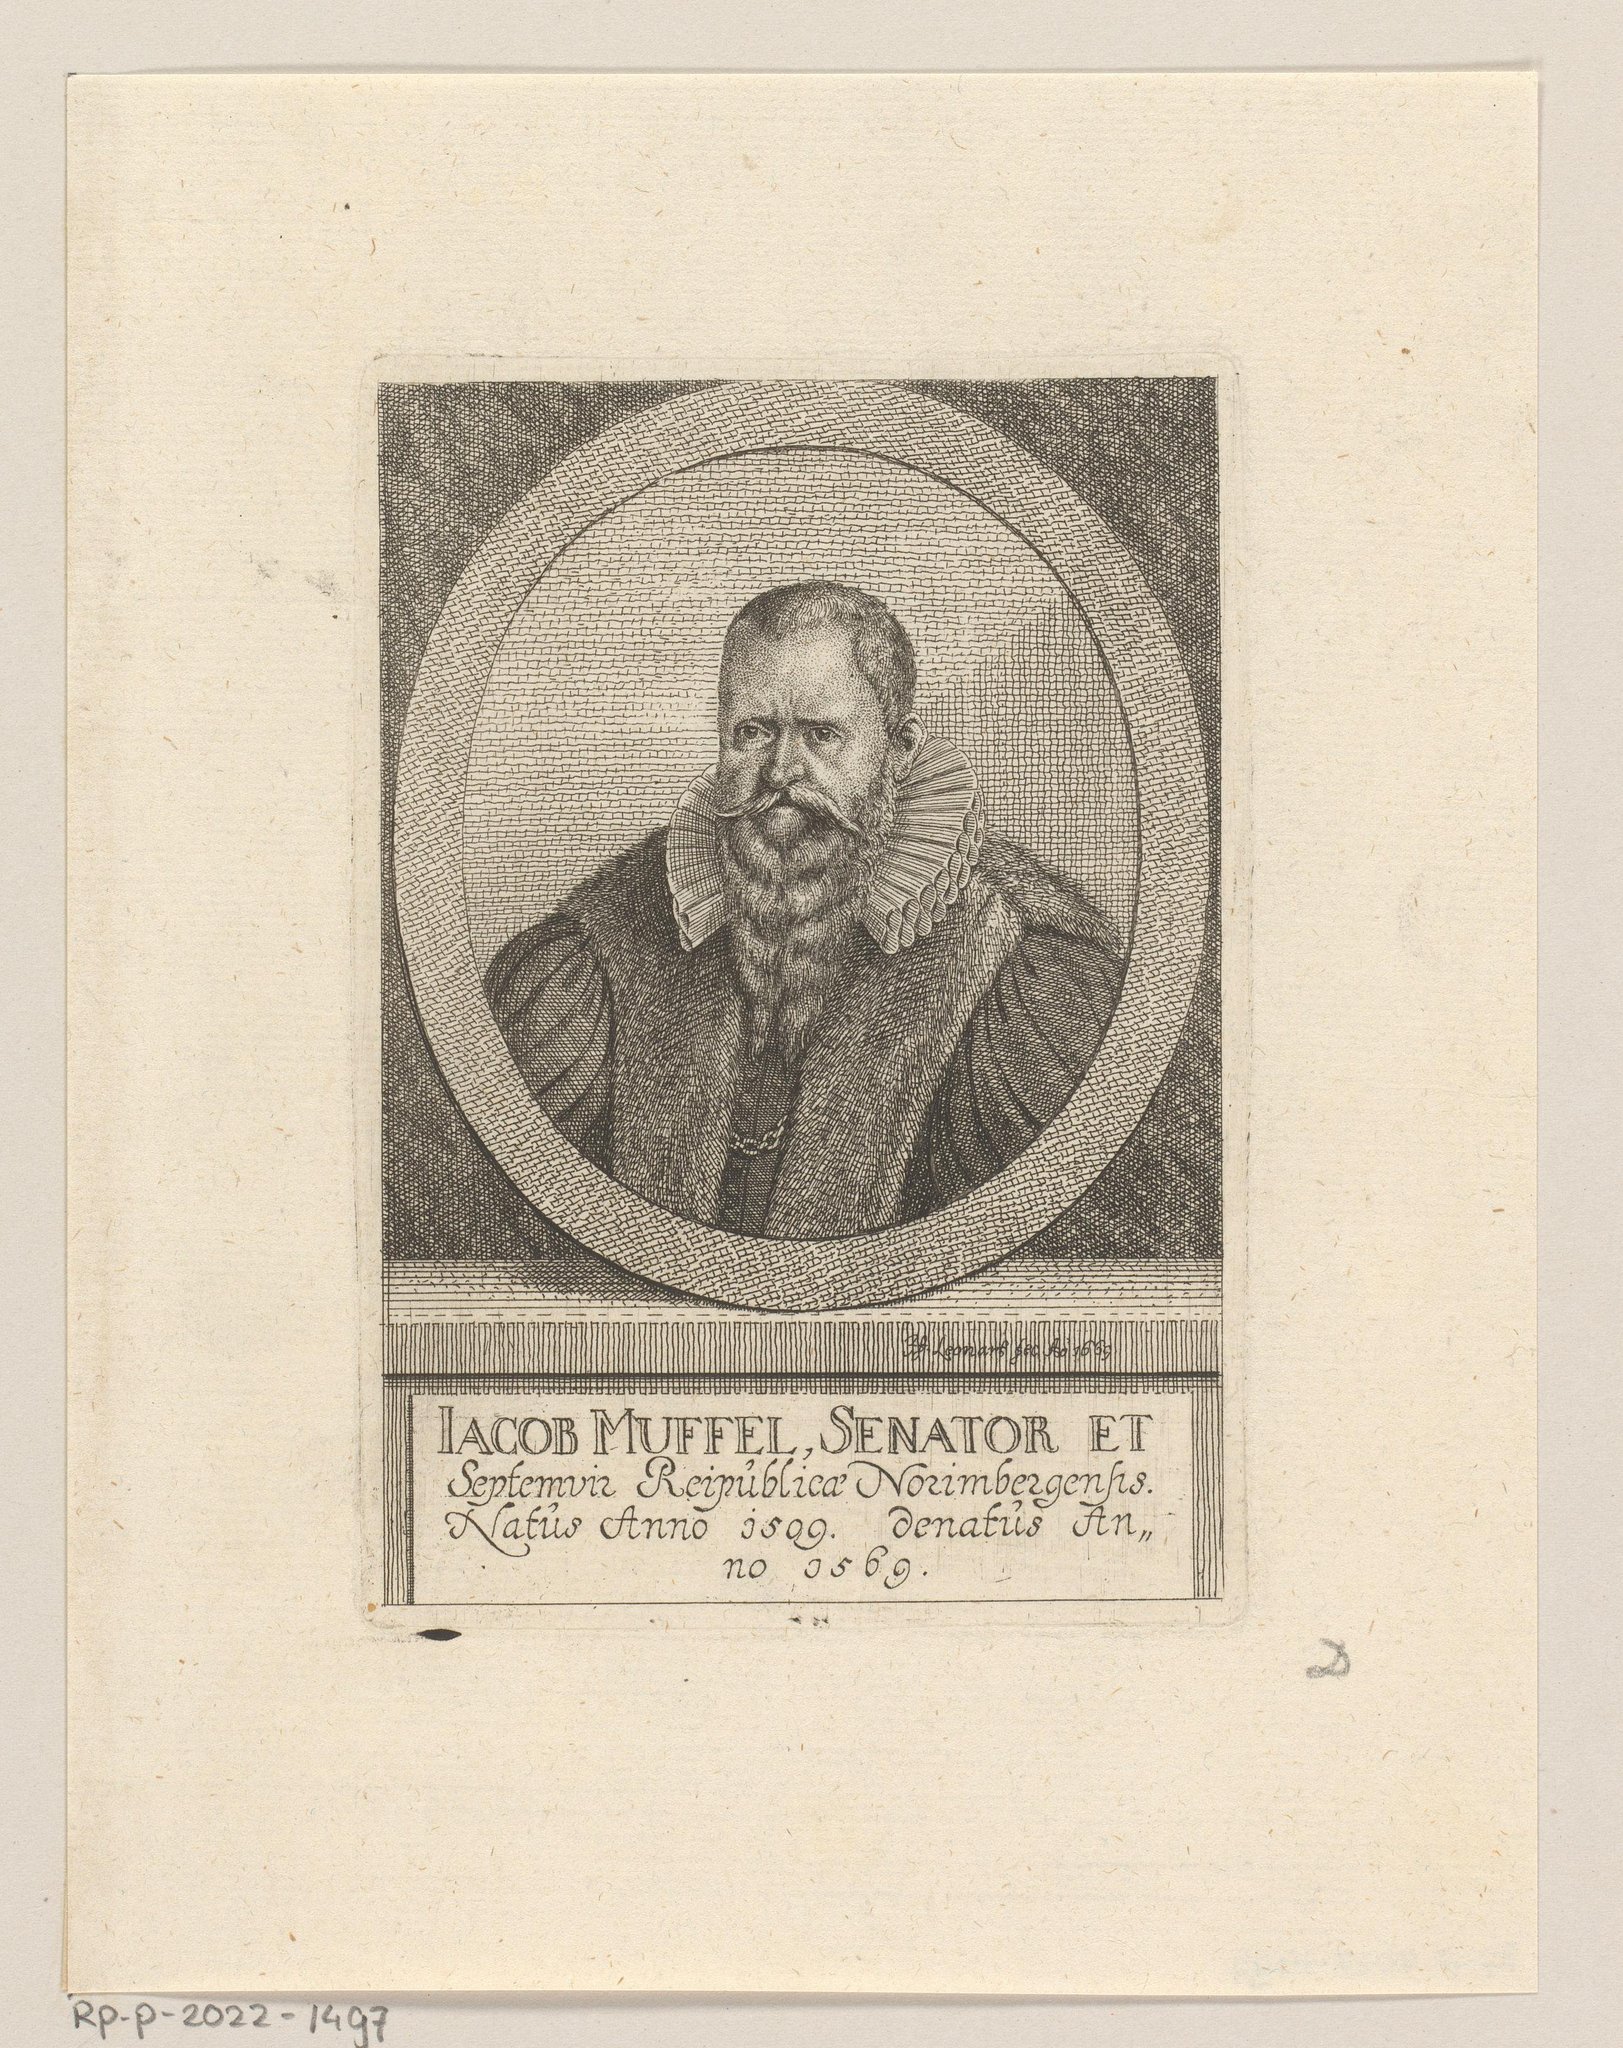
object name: print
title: Portret van Jacob Muffel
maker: johann friedrich leonard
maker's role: print maker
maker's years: 1633-1680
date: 1669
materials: paper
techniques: etching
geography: nuremberg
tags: historical persons, upper house, senate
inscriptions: collector's mark: Lugt 1337